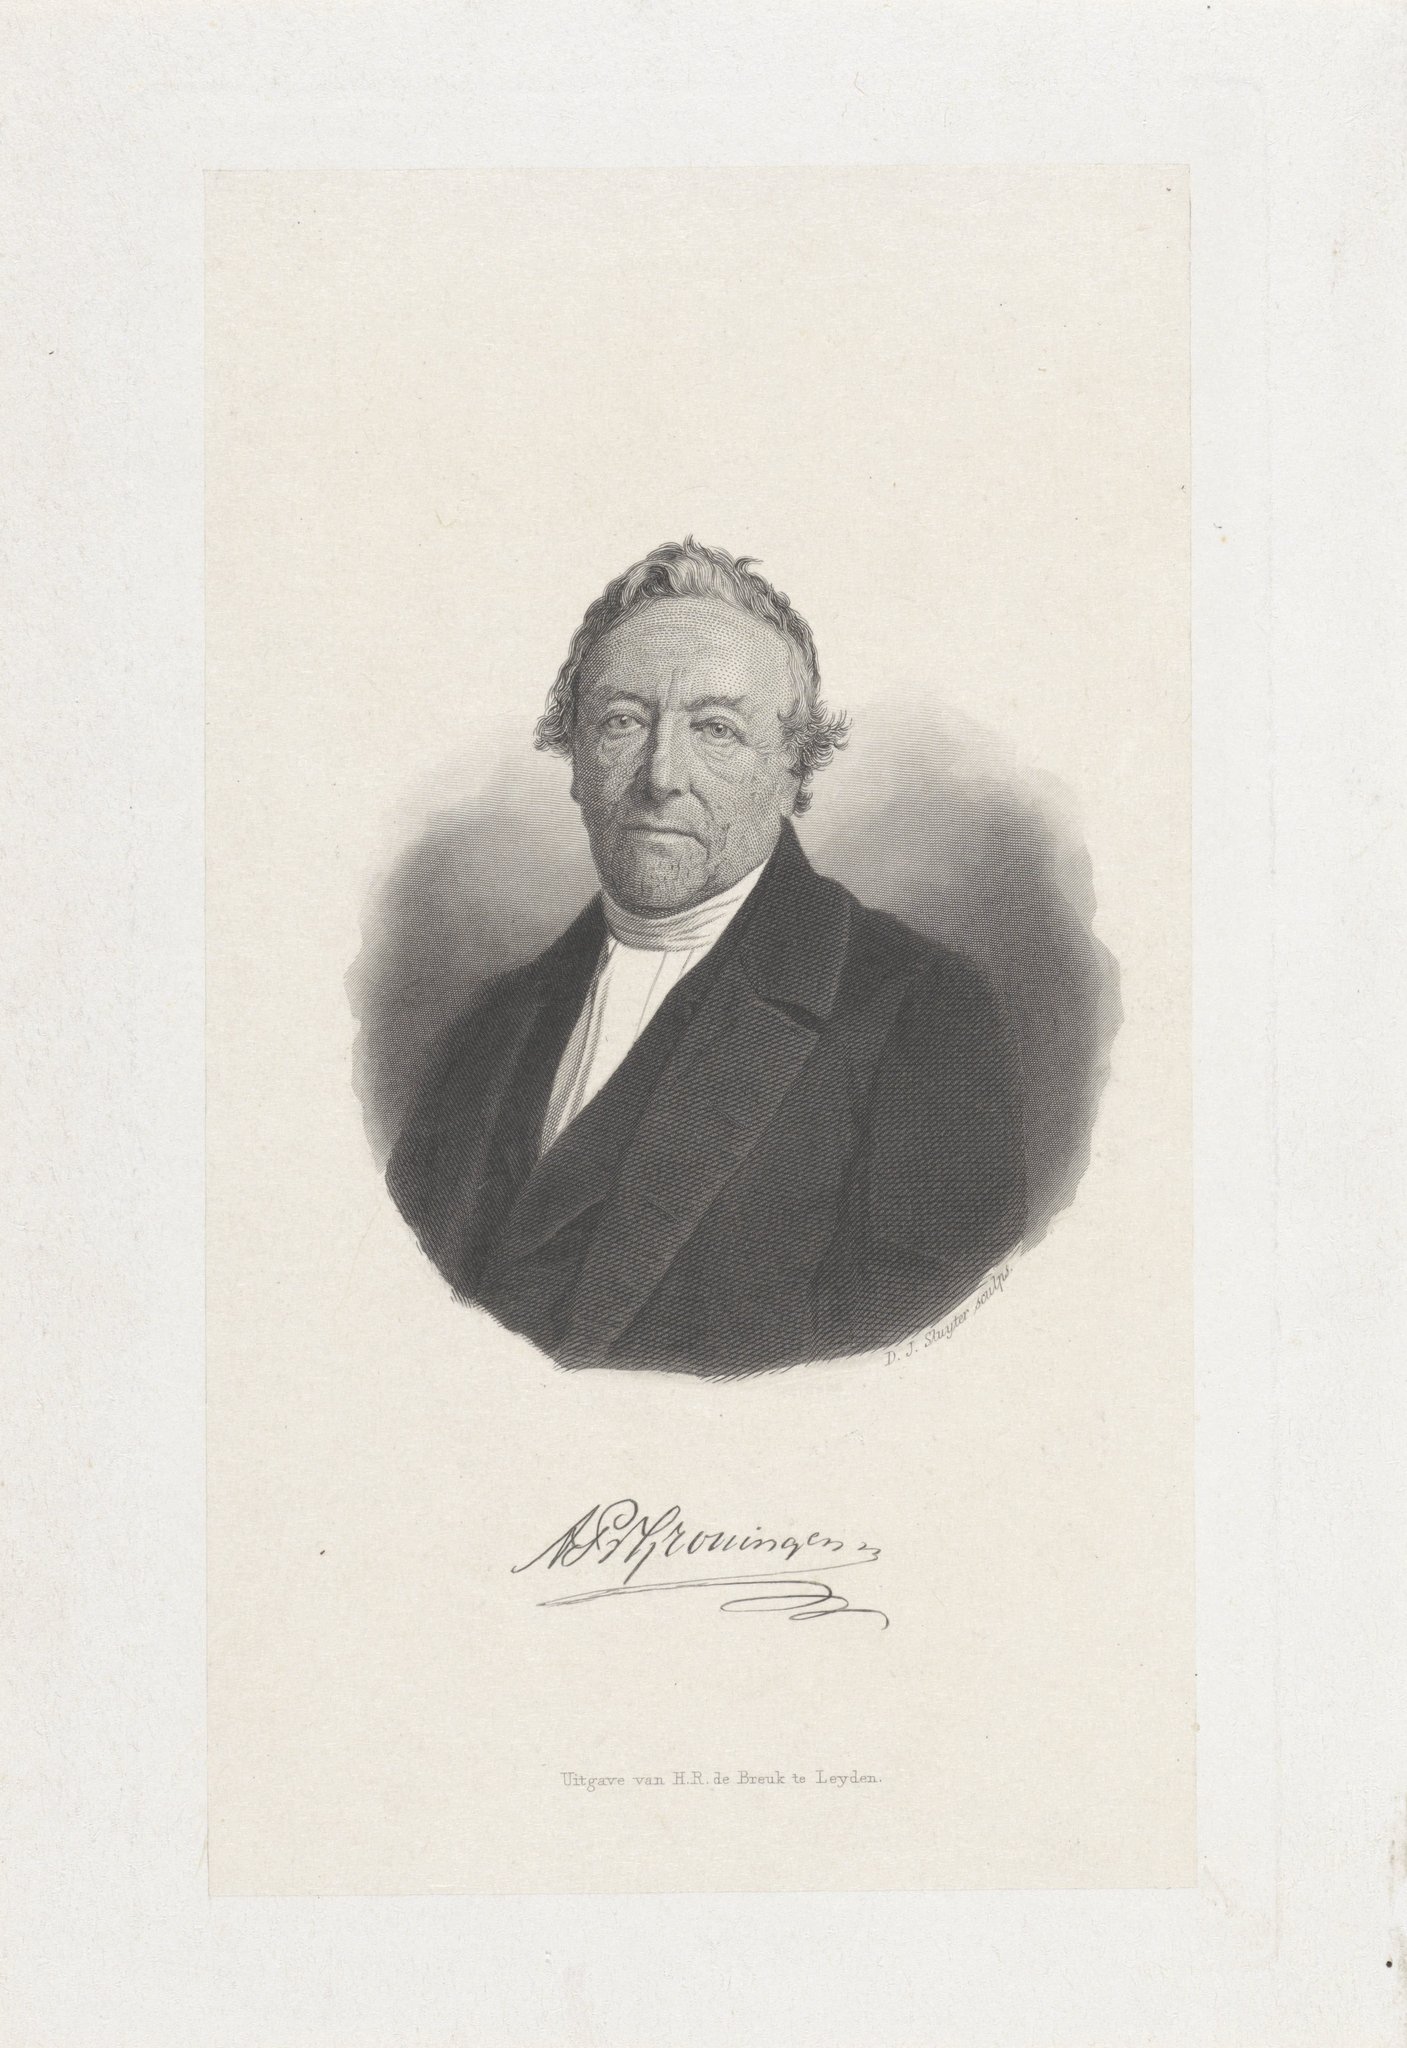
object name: print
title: Portret van de predikant Abram Pieter van Groningen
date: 1843-1855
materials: paper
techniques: etching, engraving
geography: leiden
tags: abram pieter van groningen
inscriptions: collector's mark: Lugt 2228